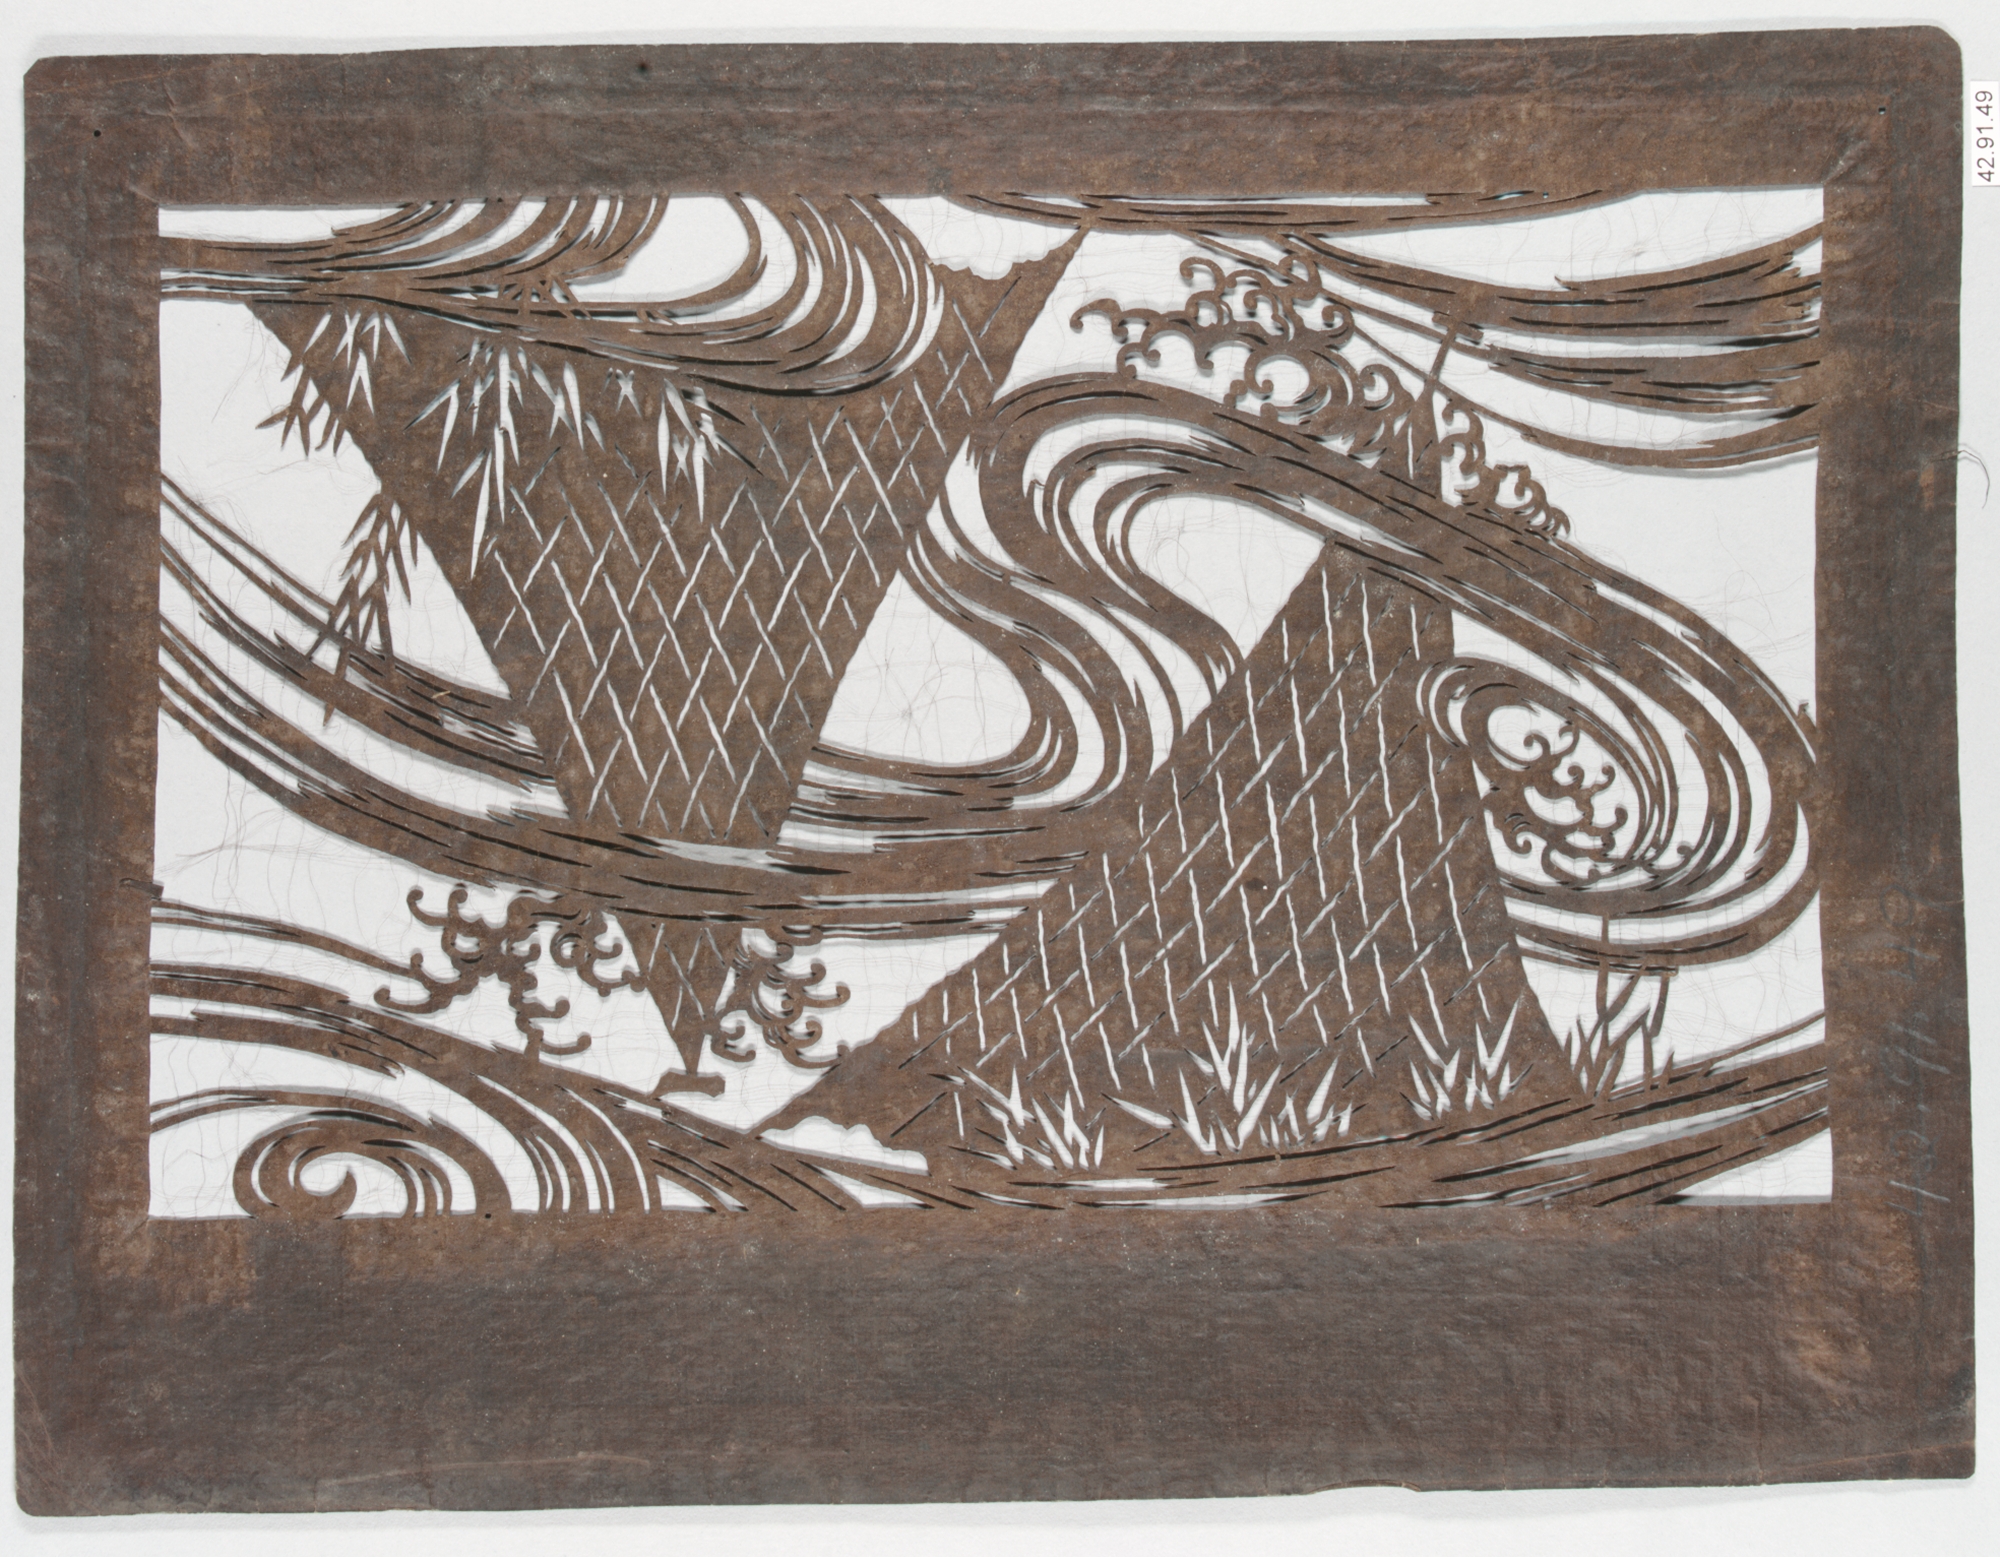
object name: stencil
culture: japanese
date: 1801-1900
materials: paper, silk